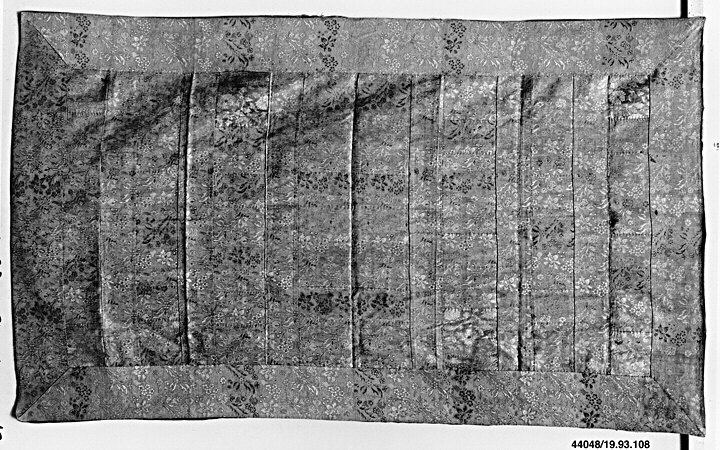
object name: robe, priest's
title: Priest's Robe (Shichijō)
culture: japanese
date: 1625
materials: metal thread, silk